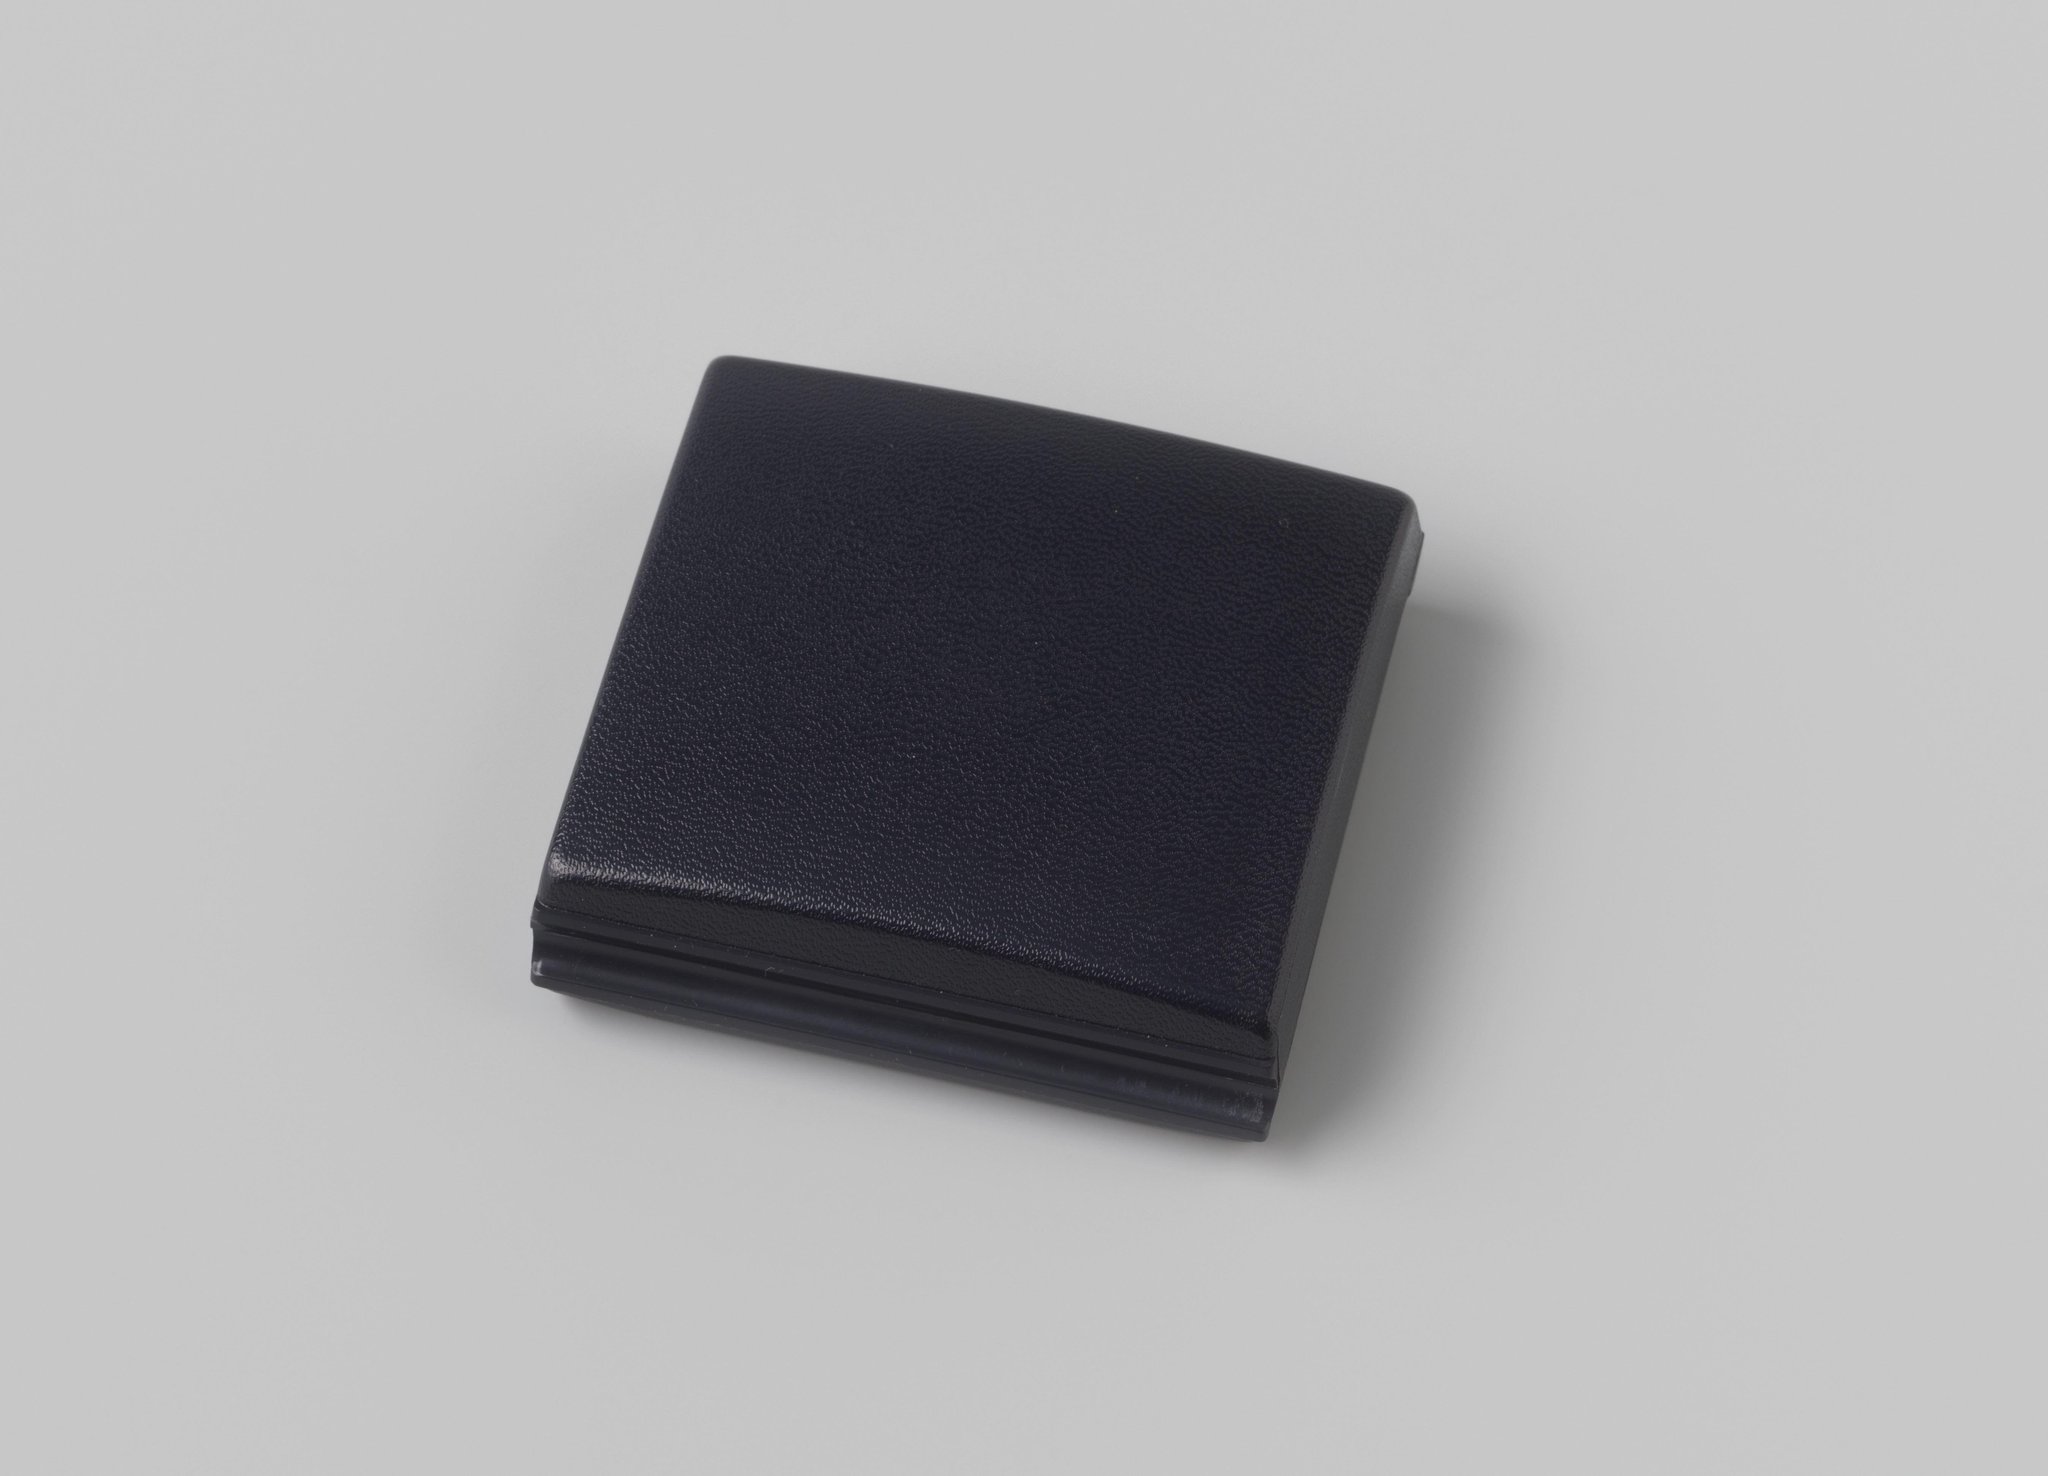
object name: box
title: Doos horend bij een bronzen penning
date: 1950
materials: plastic, velvet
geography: zoetermeer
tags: djatiroto, suikeronderneming, handels vereeniging amsterdam, jatiroto, malang, tweede wereldoorlog, nederlandse militaire acties in indonesië (1945-1949)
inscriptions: inscription: ‘QUO PATET ORBIS’, inscription: ‘AANGEBODEN DOOR DE N.V. HANDELSVEREENIGING "AMSTERDAM" TER HERINNERING AAN DE BEVRIJDING VAN DE SUIKERFABRIEK DJATIROTO 22 JULI 1947’, inscription: ‘JE MAINTIENDRAI’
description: Blauw vierkant doosje van kunststof. Binnenzijde bekleedt met blauw fluweel.